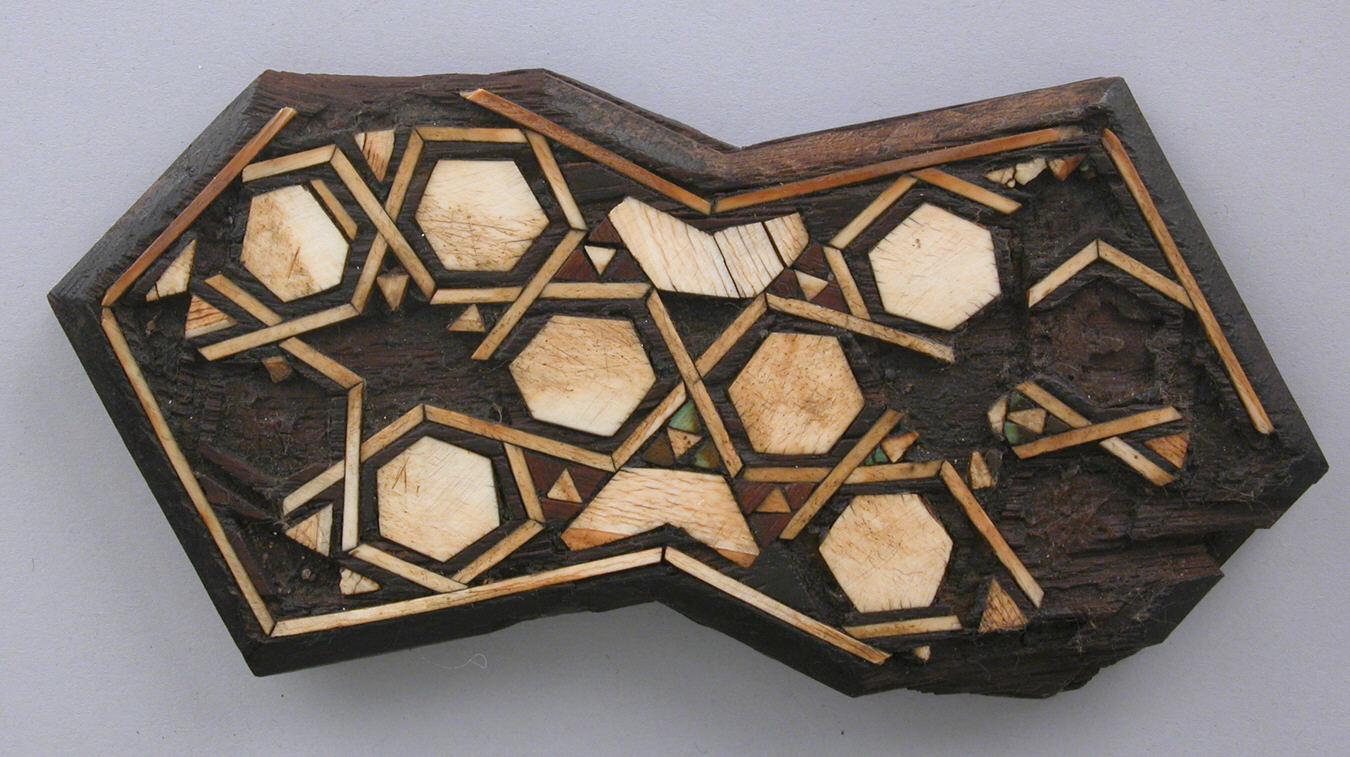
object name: panel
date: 1301-1500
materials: ivory, wood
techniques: carving, inlay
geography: egypt